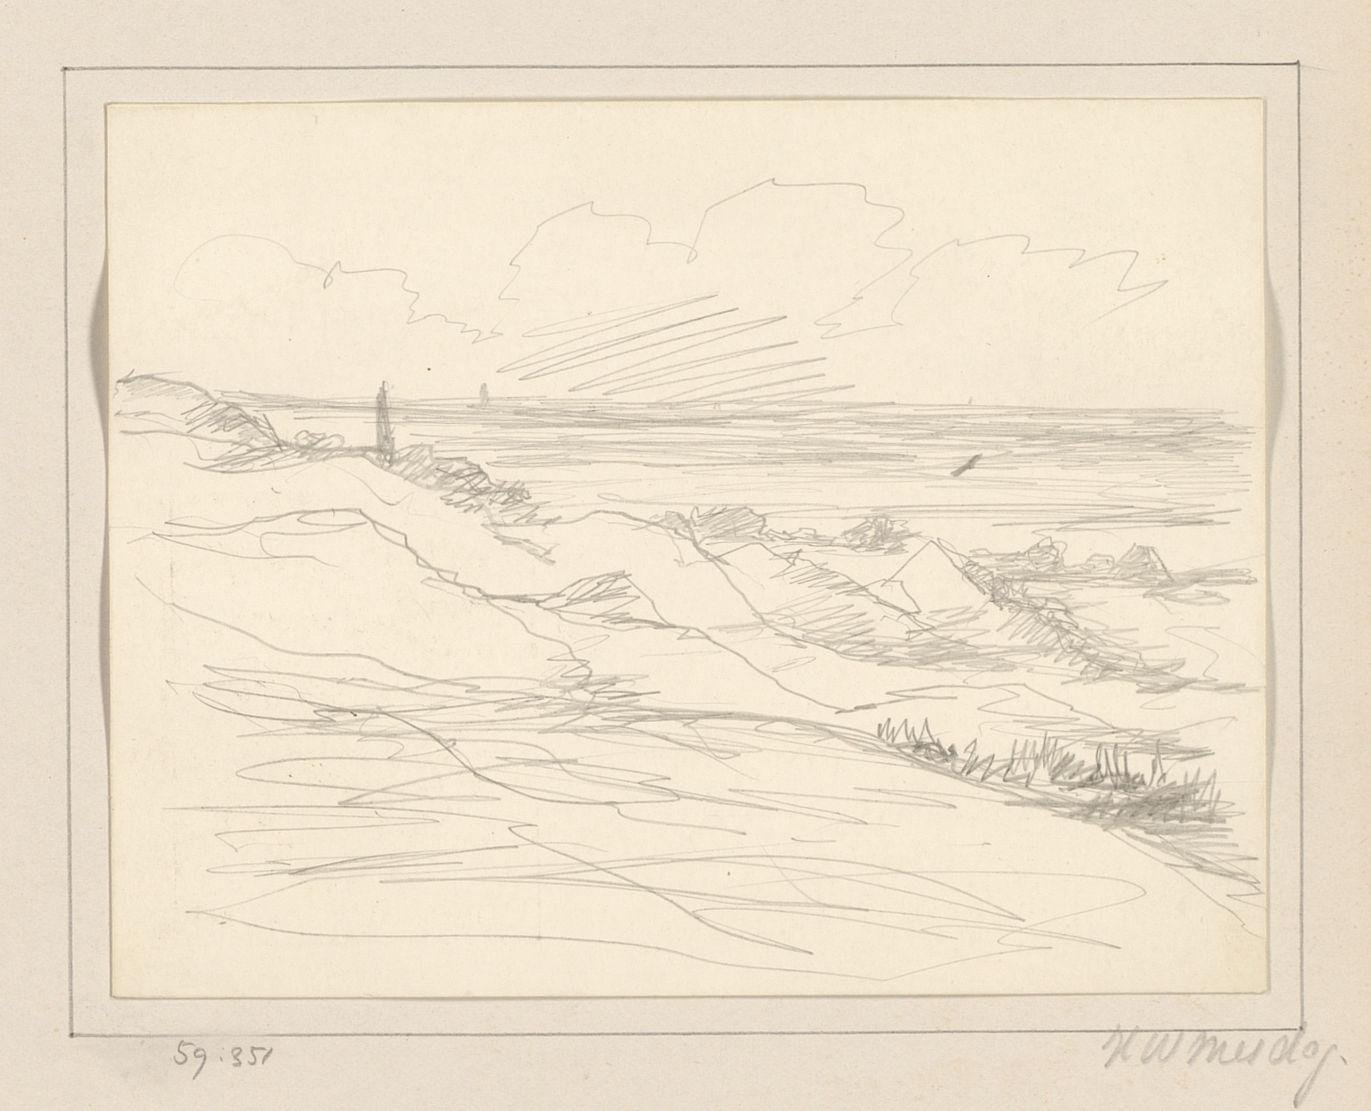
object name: drawing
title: Duinen en zee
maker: hendrik willem mesdag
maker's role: draughtsman, painter, print maker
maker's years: 1831-1915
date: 1831-1915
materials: paper, pencil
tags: dune coast, sea (seascape)